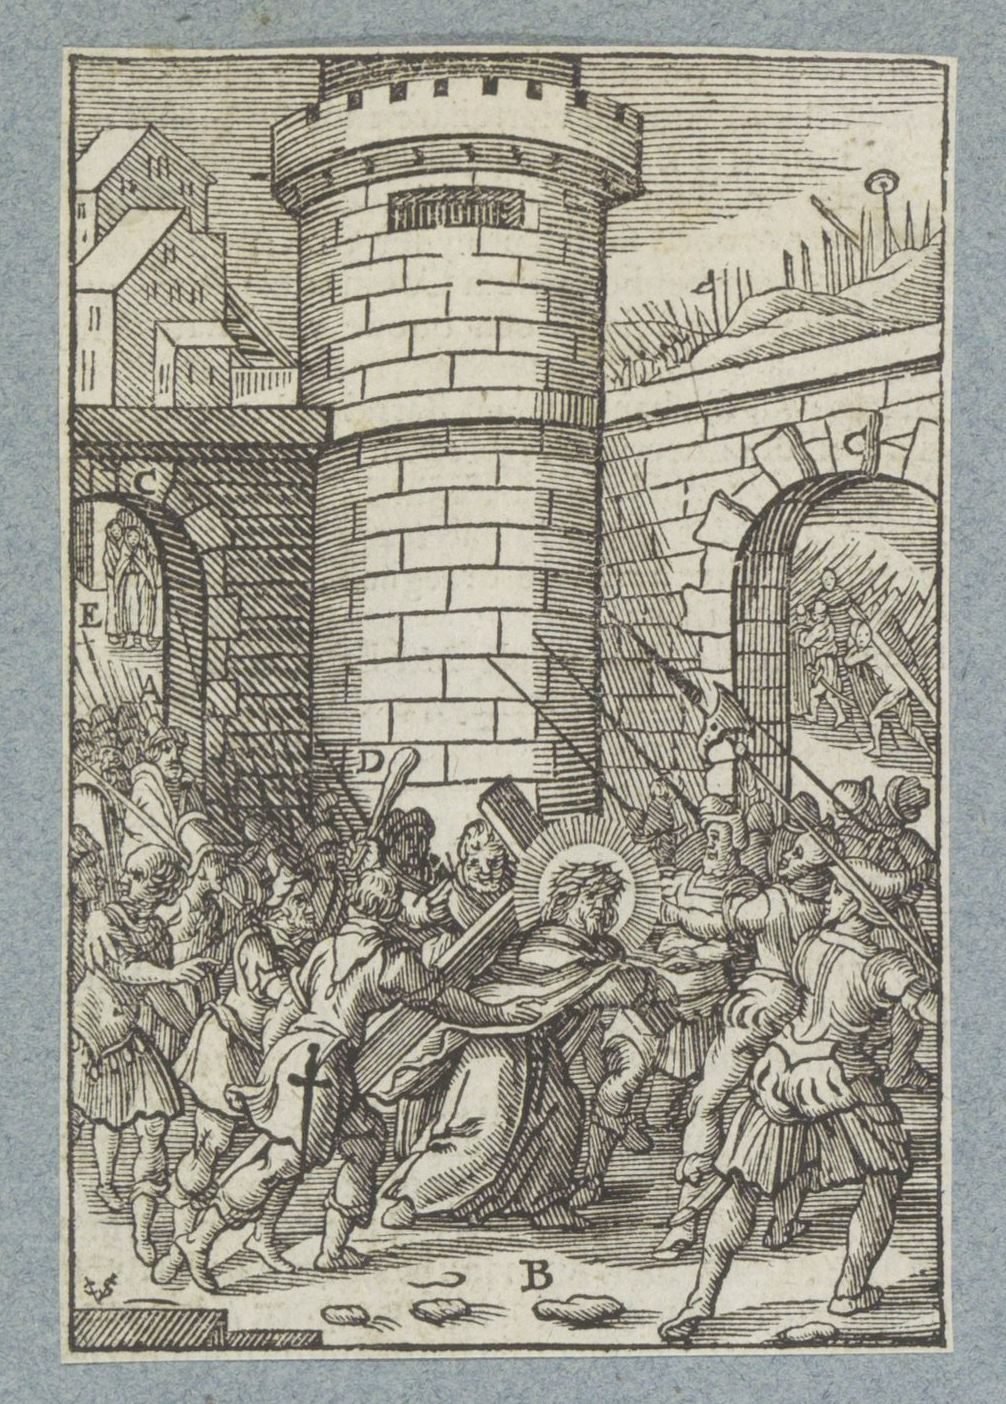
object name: book illustration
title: Kruisdraging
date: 1629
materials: paper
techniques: letterpress printing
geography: amsterdam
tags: carrying of the cross: christ bearing the cross, alone or with the help of others (e.g. simon the cyrenian)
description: De prent is afkomstig uit een van de uitgaven van P.J. Paets uit Amsterdam. De prent wordt voor het eerst gebruikt in: Der Zielen Lust-hof. Leuven, I.Jacbosz voor P.J. Paets [= Amsterdam, P.J. Paets], 1629. De voorstelling is gekopieerd naar een prent van Hieronymus Wierix voor: Nadal, Jerónimo. Evangelicae Historiae Imagines. Antwerpen, M. Nutius, 1593.